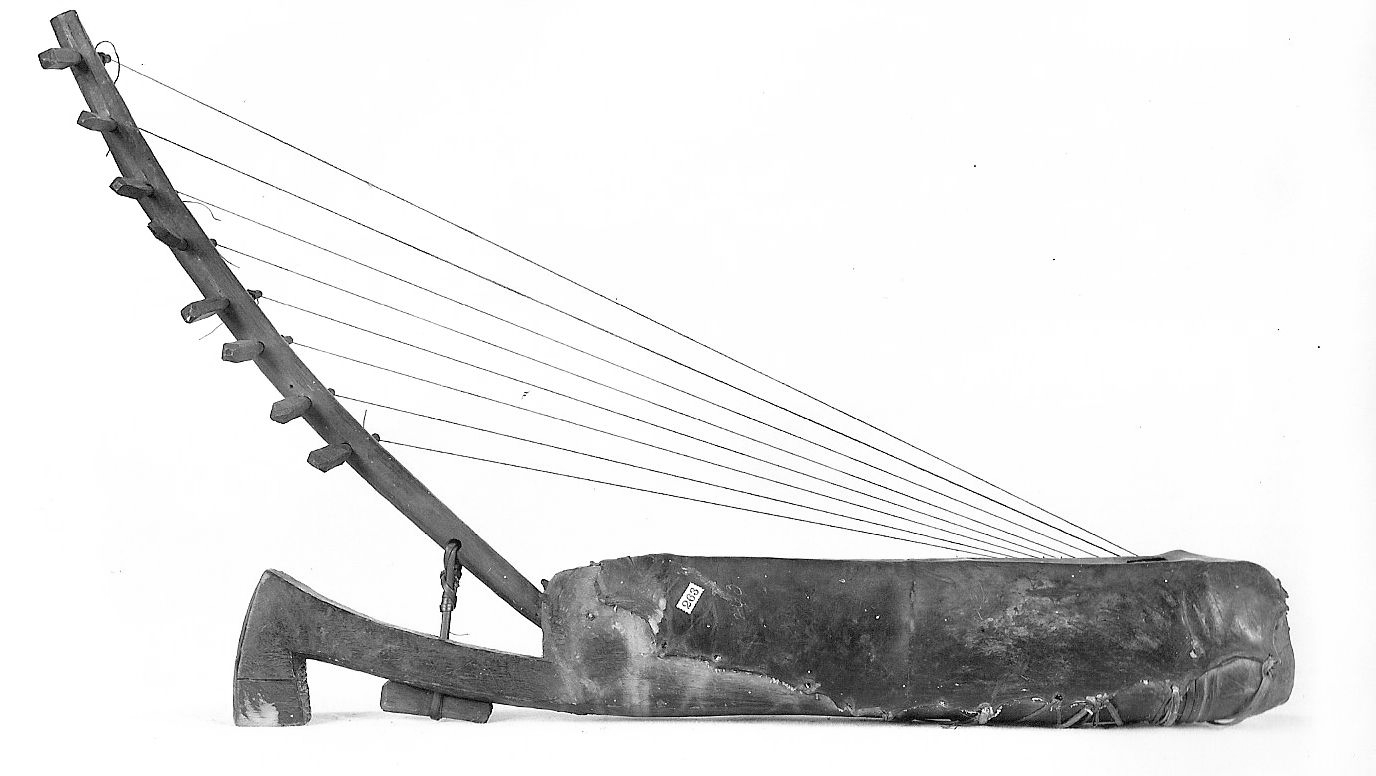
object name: ngombi ombi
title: Ngombi (ombi)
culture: fang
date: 1801-1900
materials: leather, skin, wood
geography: gabon